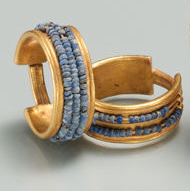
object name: earring, penannular, beaded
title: Beaded Penannular Earring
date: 1550-1425 BCE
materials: gold, lapis lazuli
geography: egypt